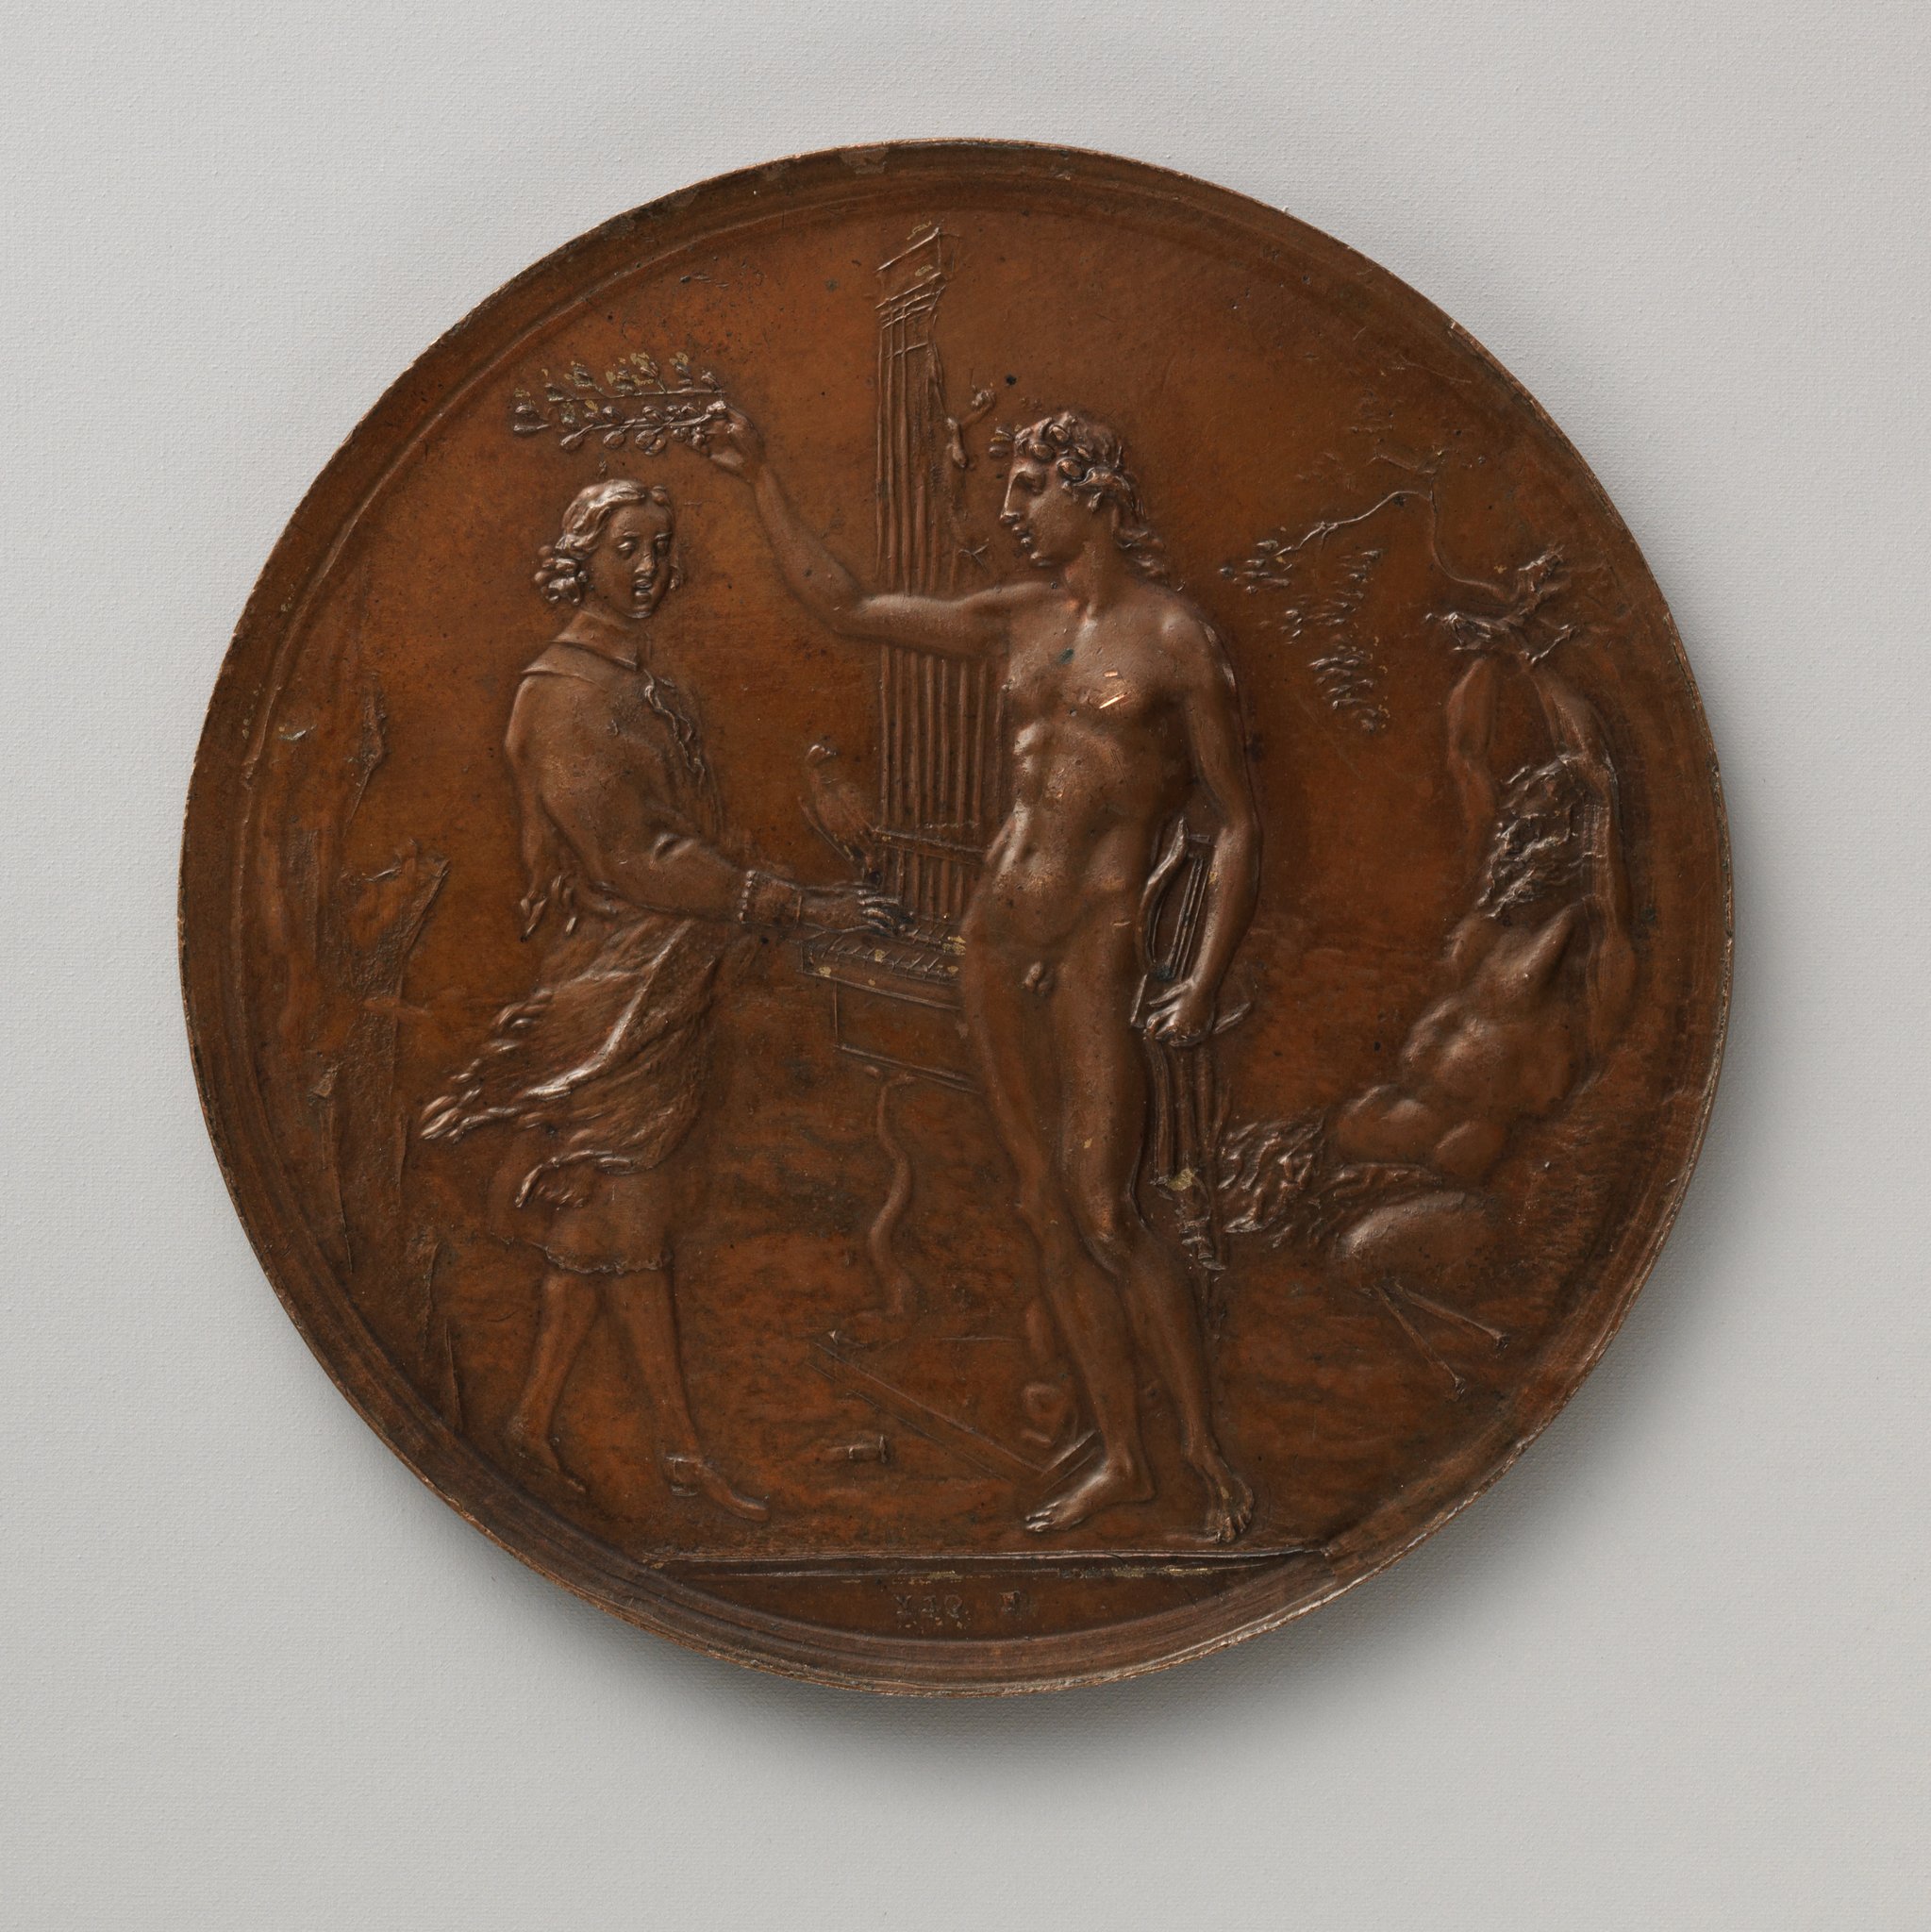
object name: medal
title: Academy of Ancient Music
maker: richard yeo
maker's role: artist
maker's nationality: british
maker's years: 1720-1779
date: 1750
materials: bronze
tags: male nudes,women